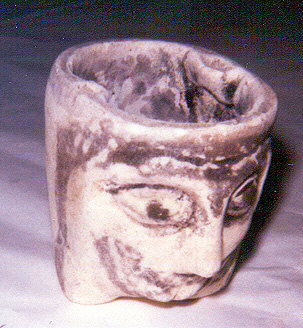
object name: bowl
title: Bowl with human head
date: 2000-1001 BCE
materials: faience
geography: syria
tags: heads